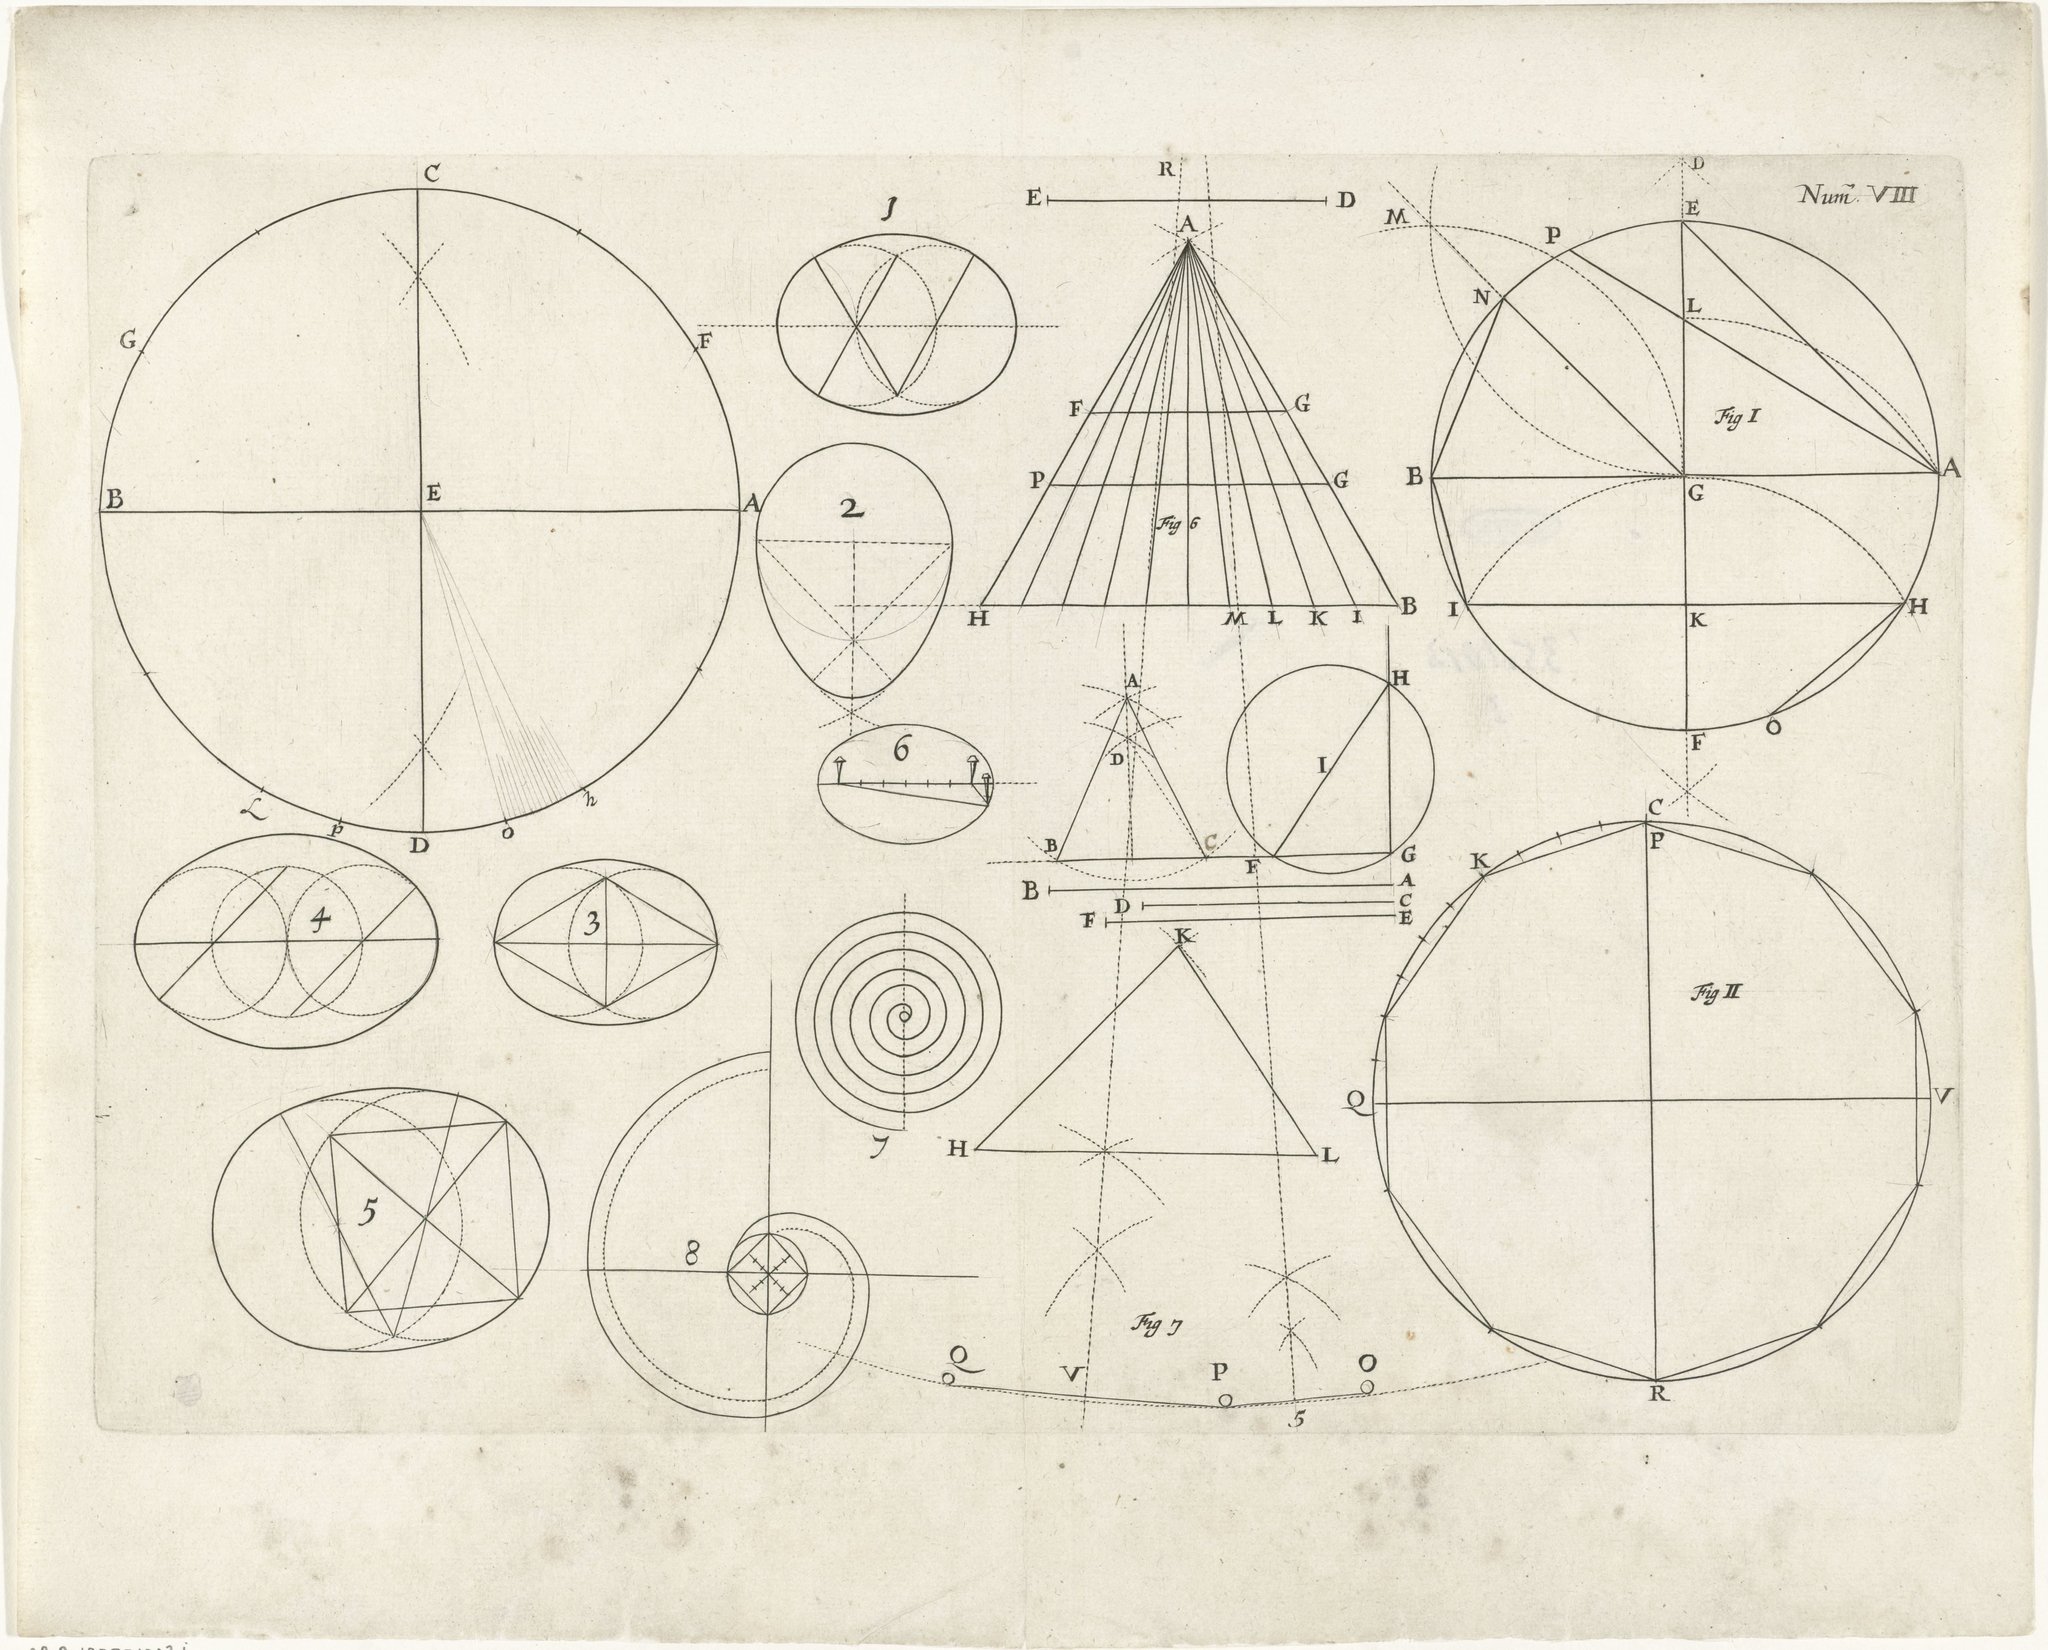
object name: book illustration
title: Blad met meetkundige figuren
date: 1654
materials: paper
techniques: engraving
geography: amsterdam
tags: ornament ~ geometric motifs (+ ornament enlivened by human forms)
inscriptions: collector's mark: Lugt 2228, collector's mark: Lugt 2760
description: Illustratie voor: Henrich Ruse. Versterckte Vesting. Amsterdam: Johannes Willemszoon Blaeu, 1654.